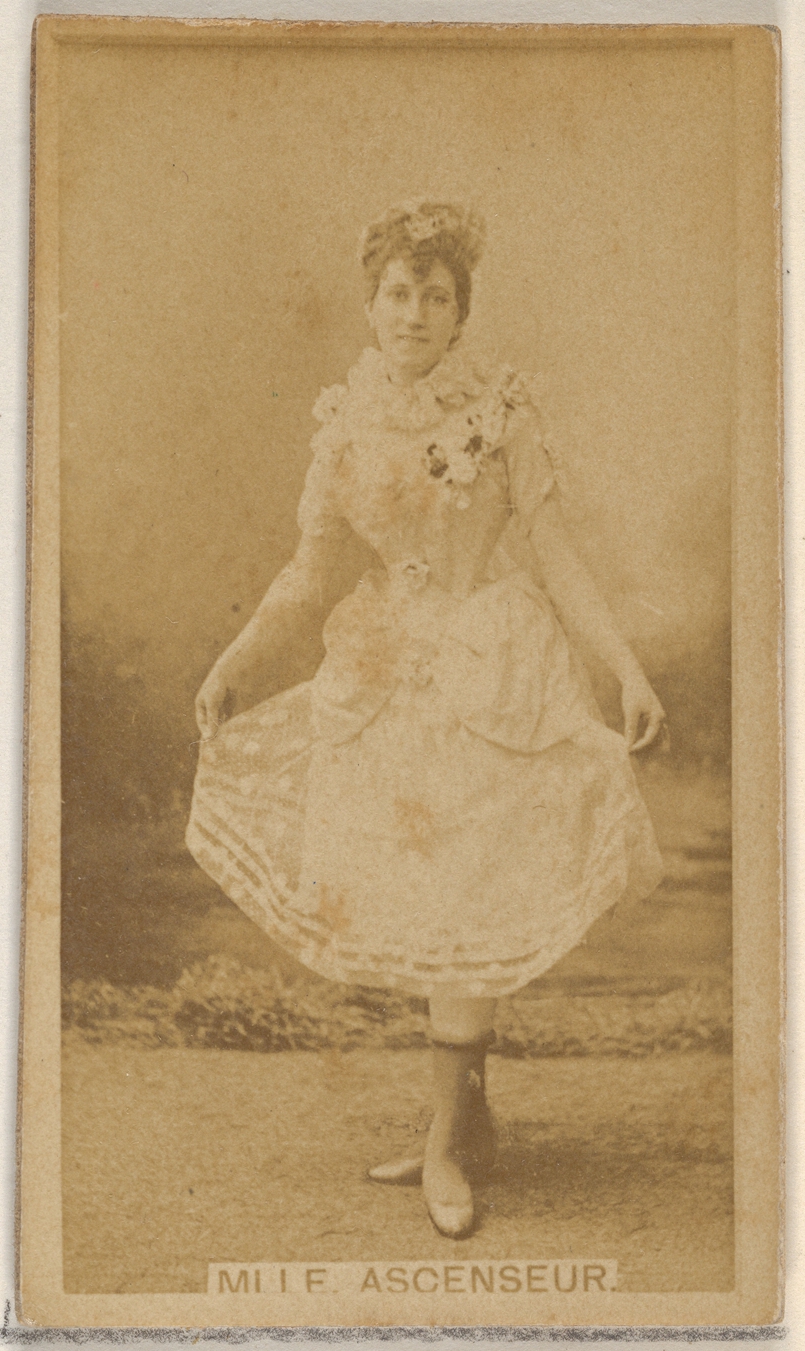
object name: photograph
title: Mlle. Ascenseur, from the Actors and Actresses series (N45, Type 8) for Virginia Brights Cigarettes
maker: allen & ginter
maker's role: publisher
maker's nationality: american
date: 1888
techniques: albumen silver print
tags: portraits,women,actresses